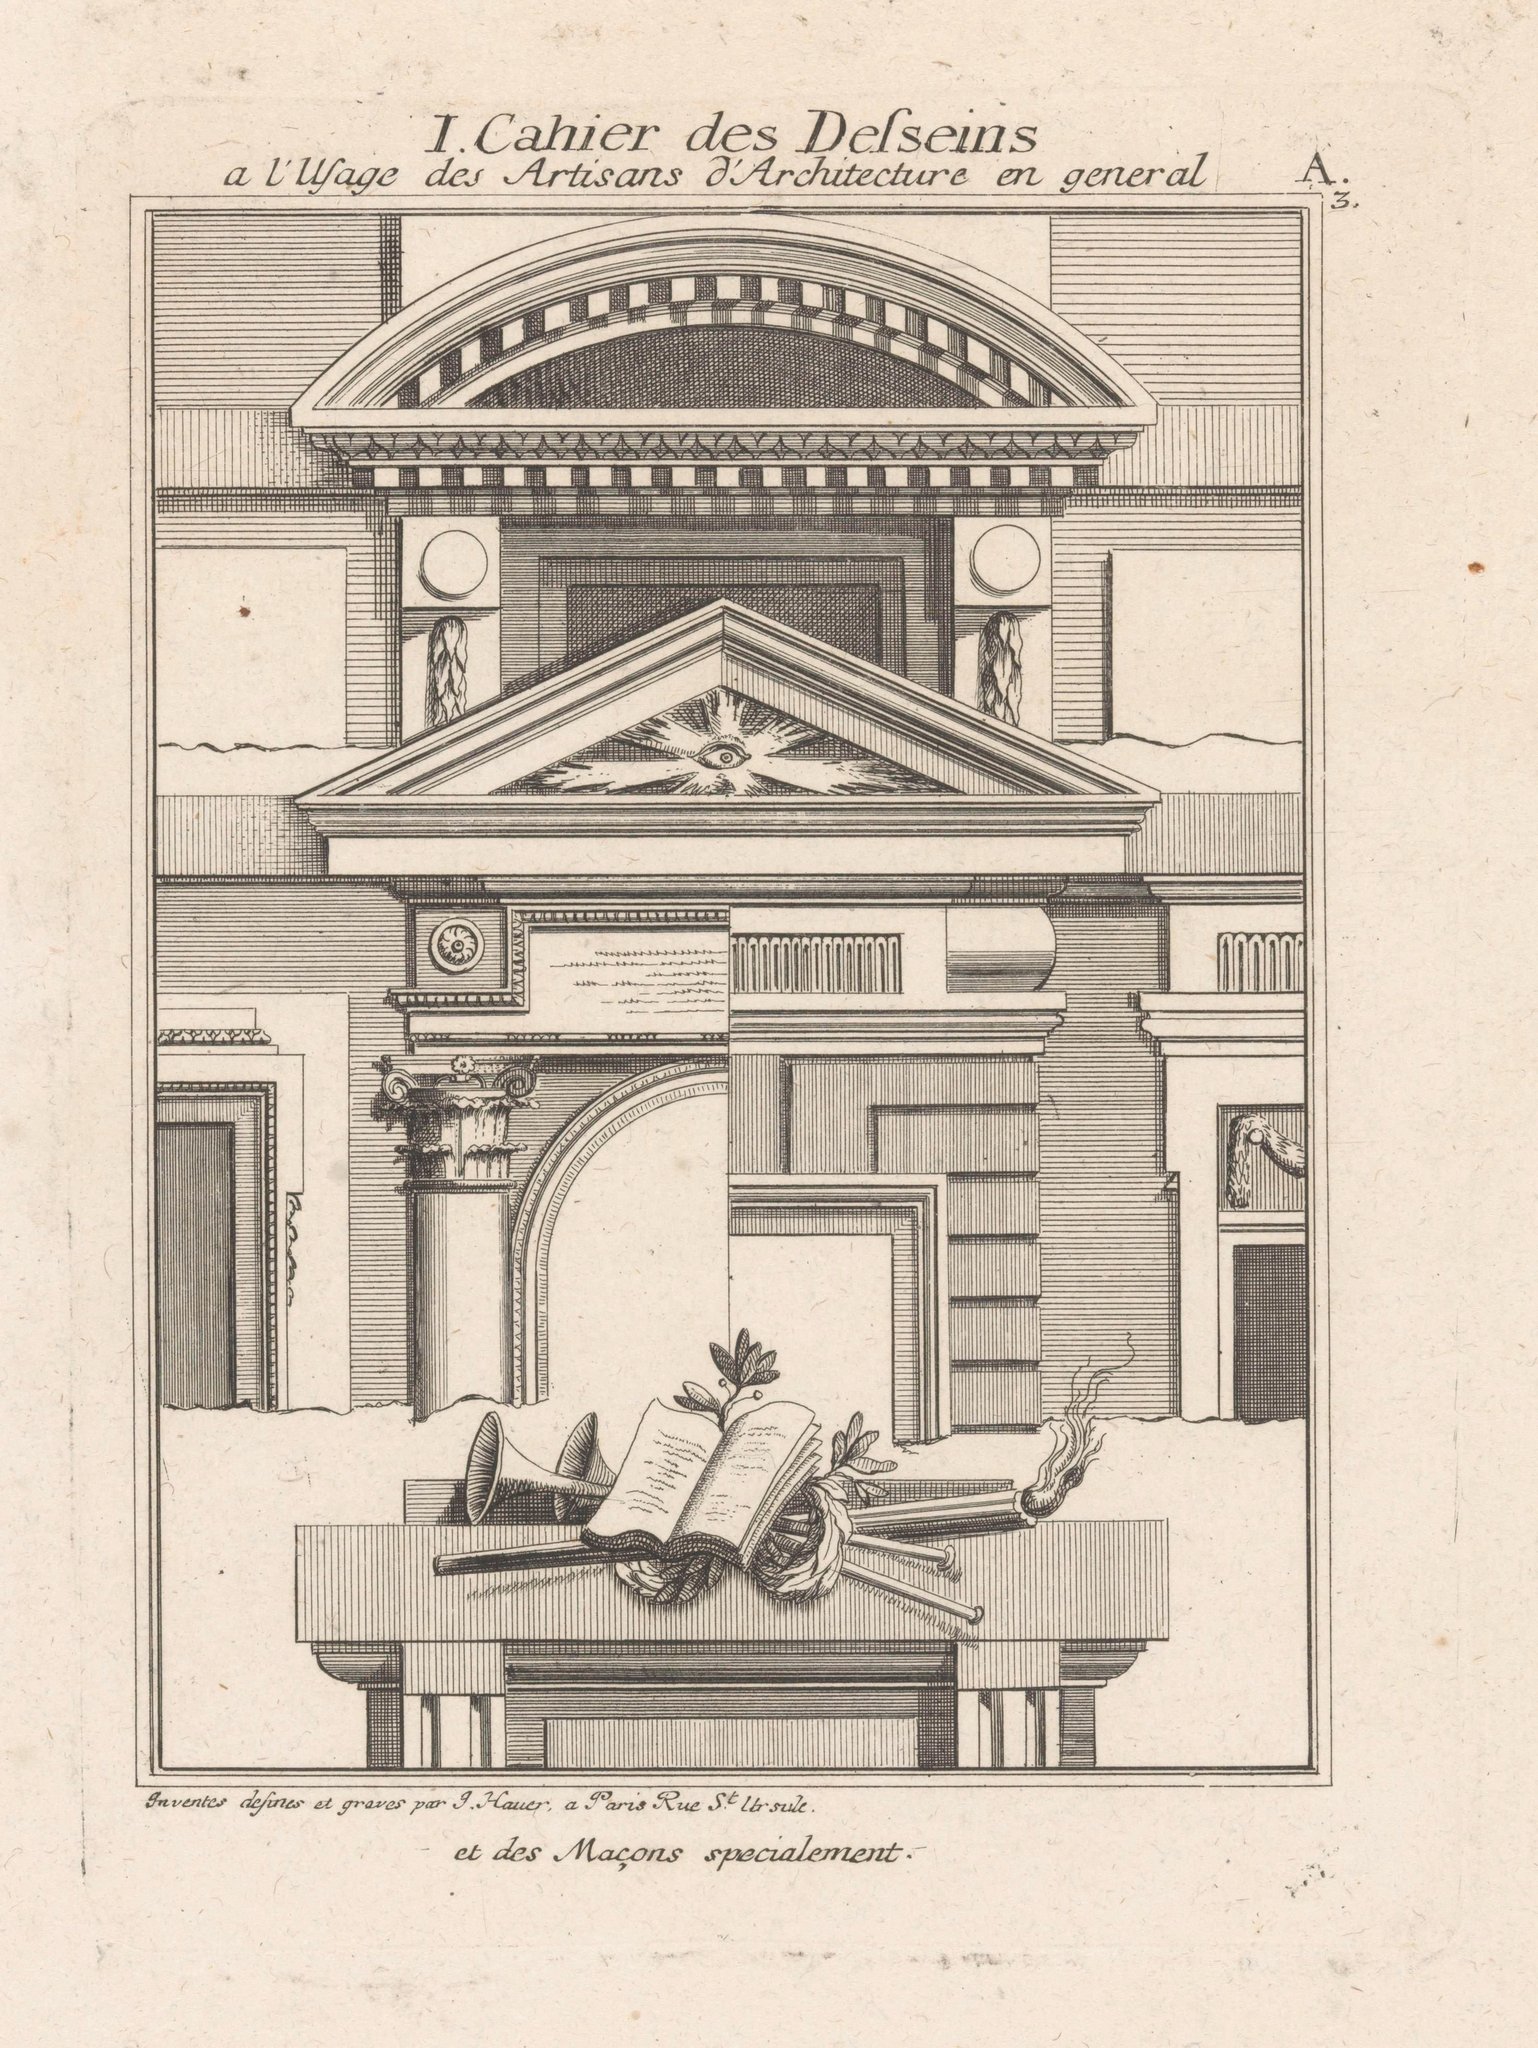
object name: ornament print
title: I Cahier par les Maçons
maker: johann thomas hauer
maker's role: print maker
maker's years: 1748-1820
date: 1758-1820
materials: paper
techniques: engraving, etching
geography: paris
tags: monumental door, porch, 'aediculum', architectural design or model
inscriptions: collector's mark: Lugt 2760, collector's mark: Lugt 2228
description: Ontwerpen voor een driehoekig en segmentvormig fronton en portalen. Onderaan een geopend boek, lauwerkransen, bazuinen en een fakkel.